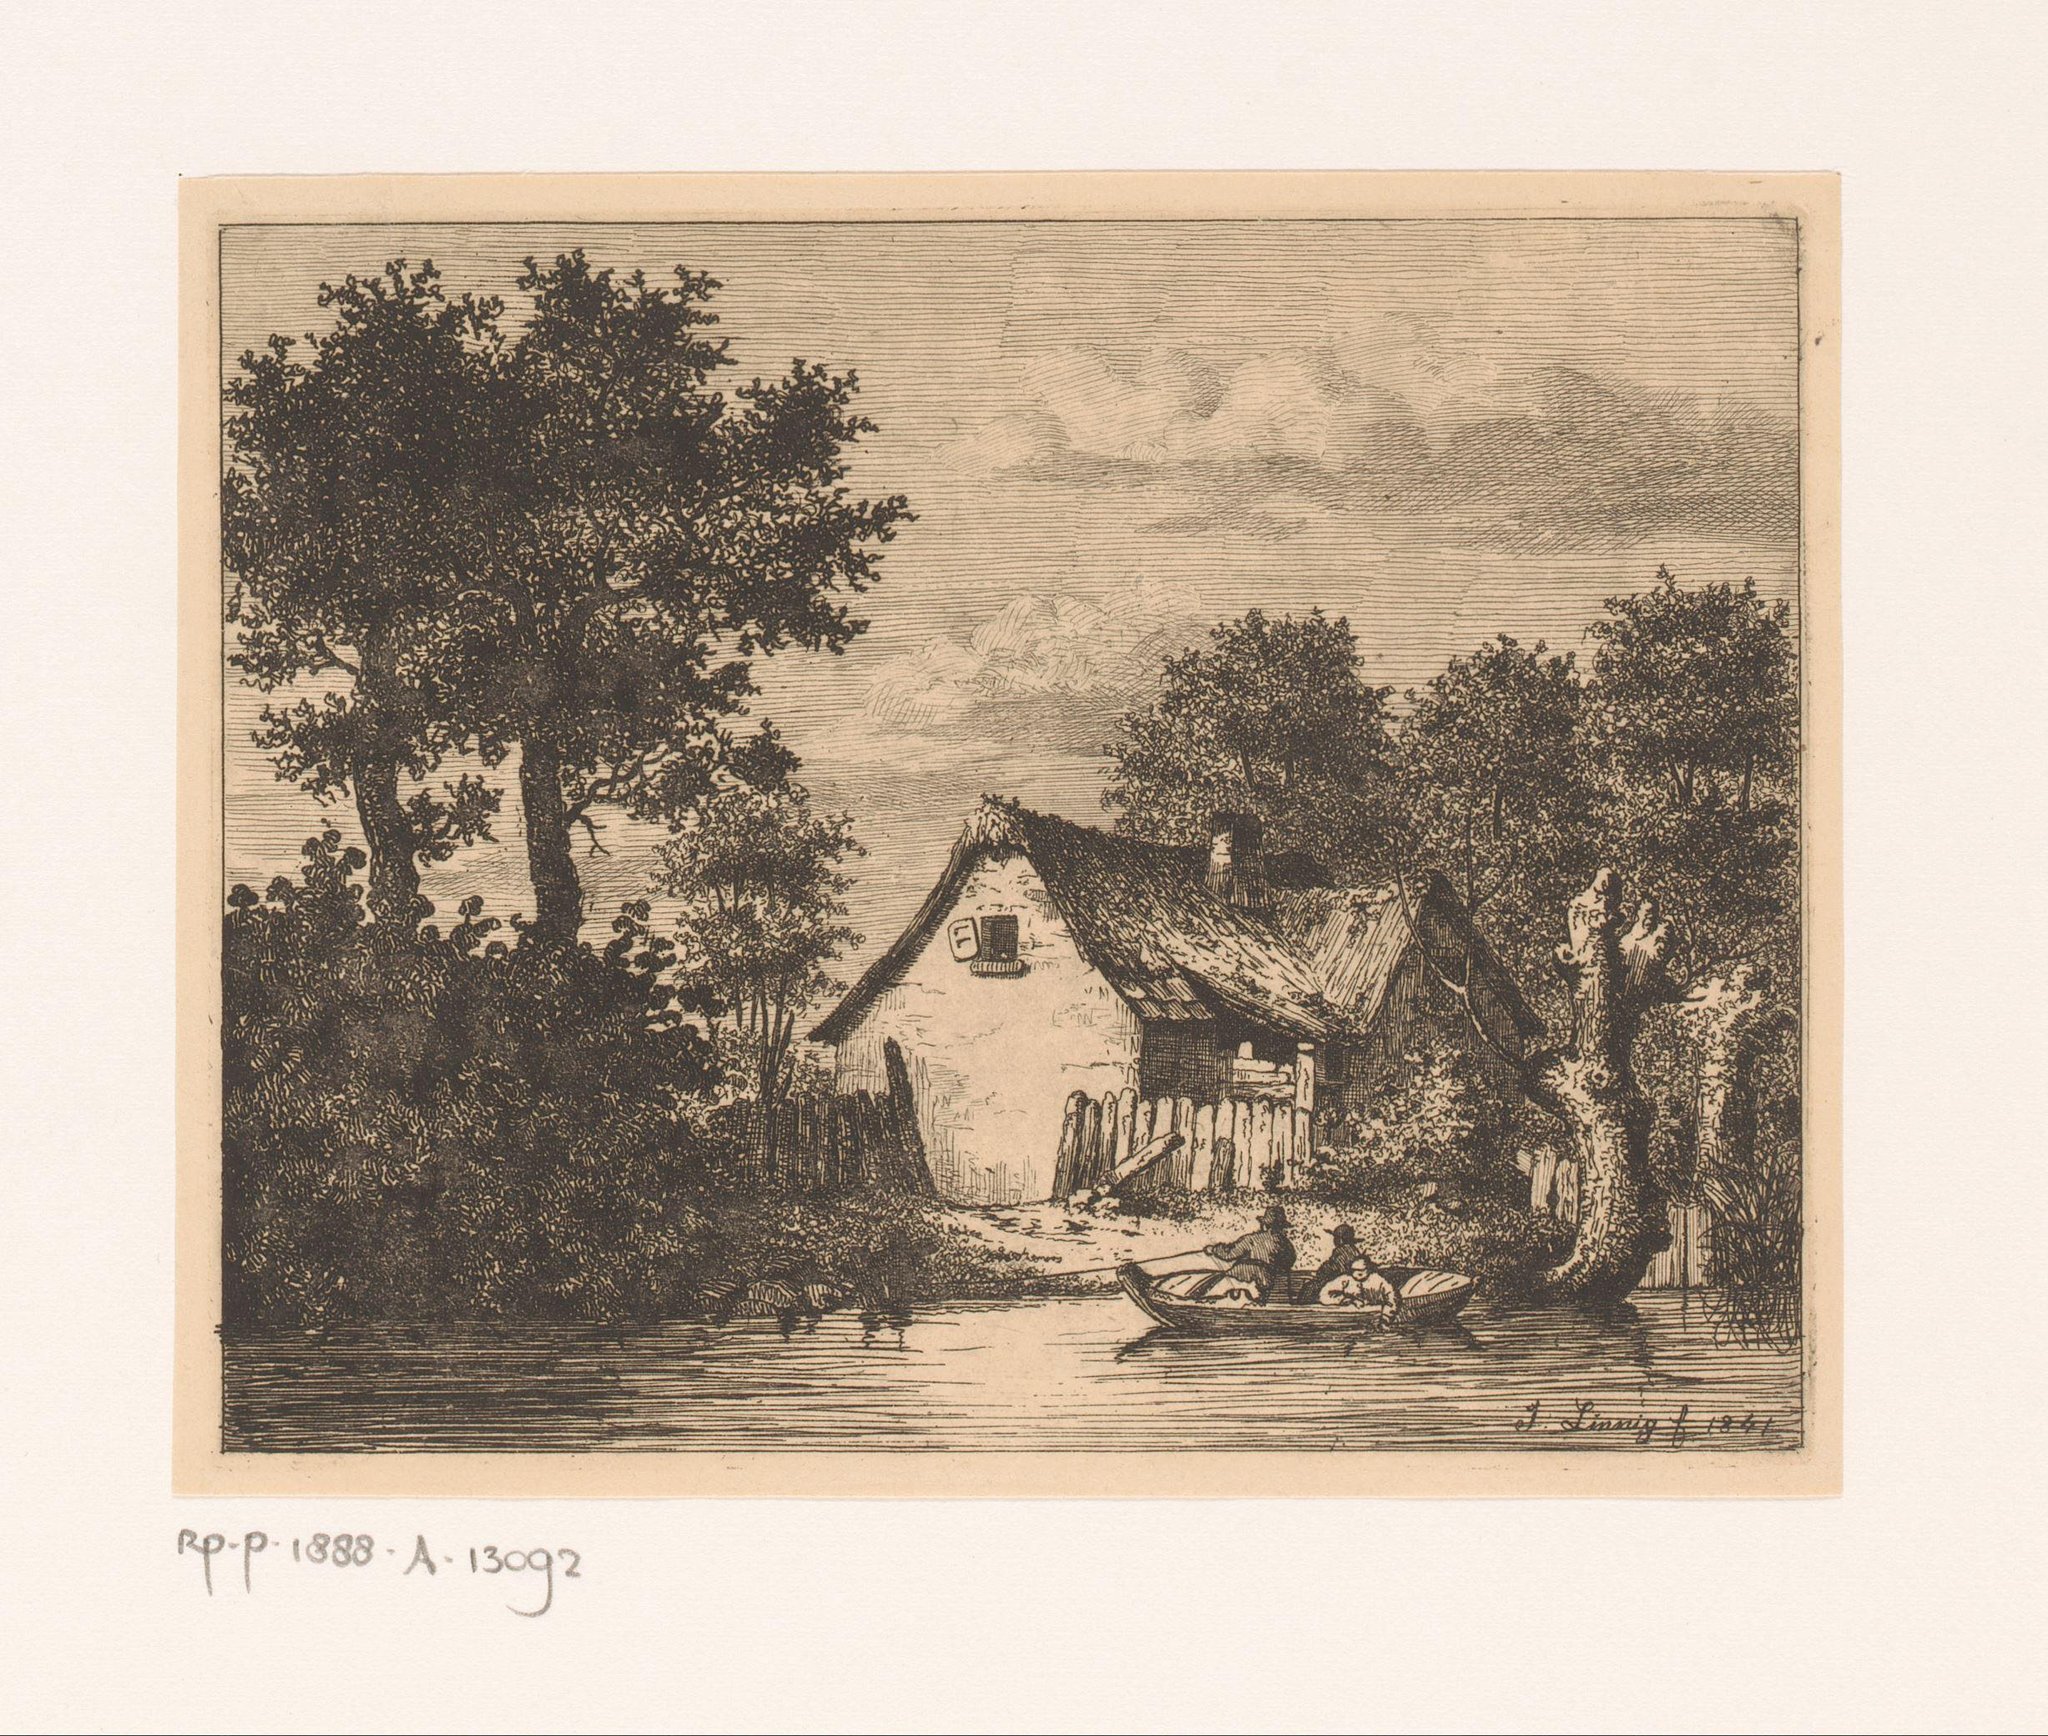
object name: print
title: Roeiboot op een rivier voor een boerderij in Wetteren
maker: jean théodore joseph linnig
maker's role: draughtsman, print maker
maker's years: 1815-1891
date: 1841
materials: paper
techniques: etching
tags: rowing-boat, canoe, etc., farm or solitary house in landscape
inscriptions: collector's mark: Lugt 2228